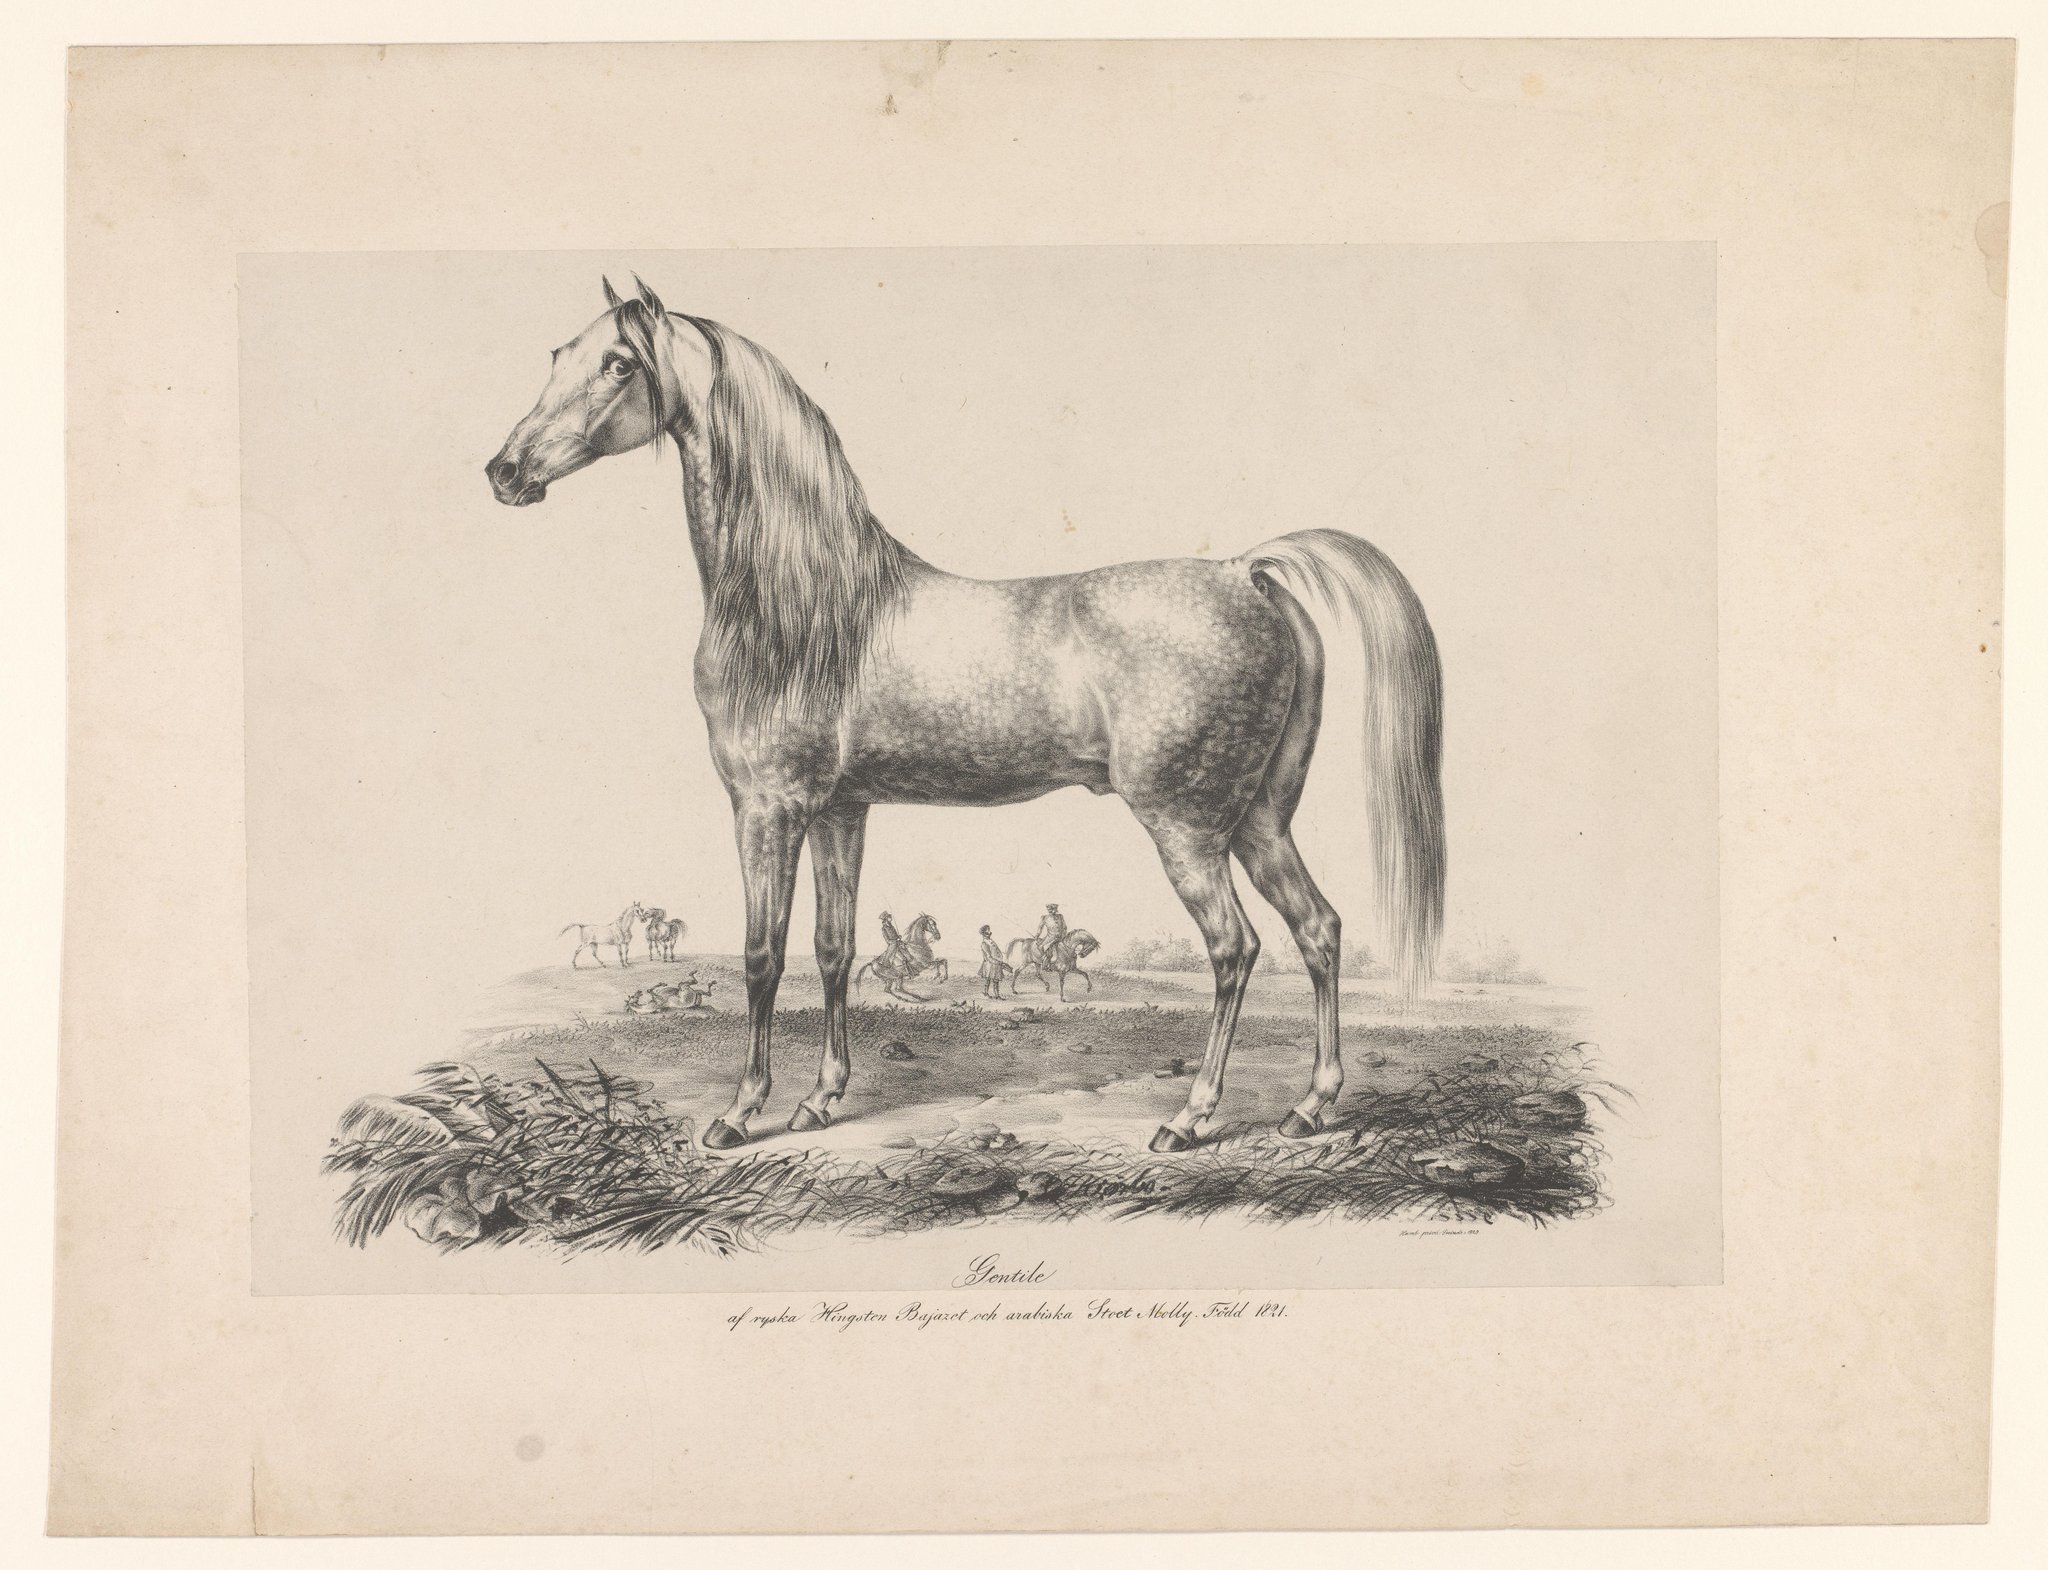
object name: print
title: Paard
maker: carl fredrik kiörböe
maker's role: print maker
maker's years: 1799-1876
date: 1829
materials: paper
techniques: lithograph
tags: horse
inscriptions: signature: ‘Hamb. privil. Steindr. 1829’, signature: ‘CFKiörbo’, collector's mark: Lugt 2228, title: ‘Gentile’, inscription: ‘af ryska Hingsten Bajazet och arabiska Stoet Molly. Född 1821.’